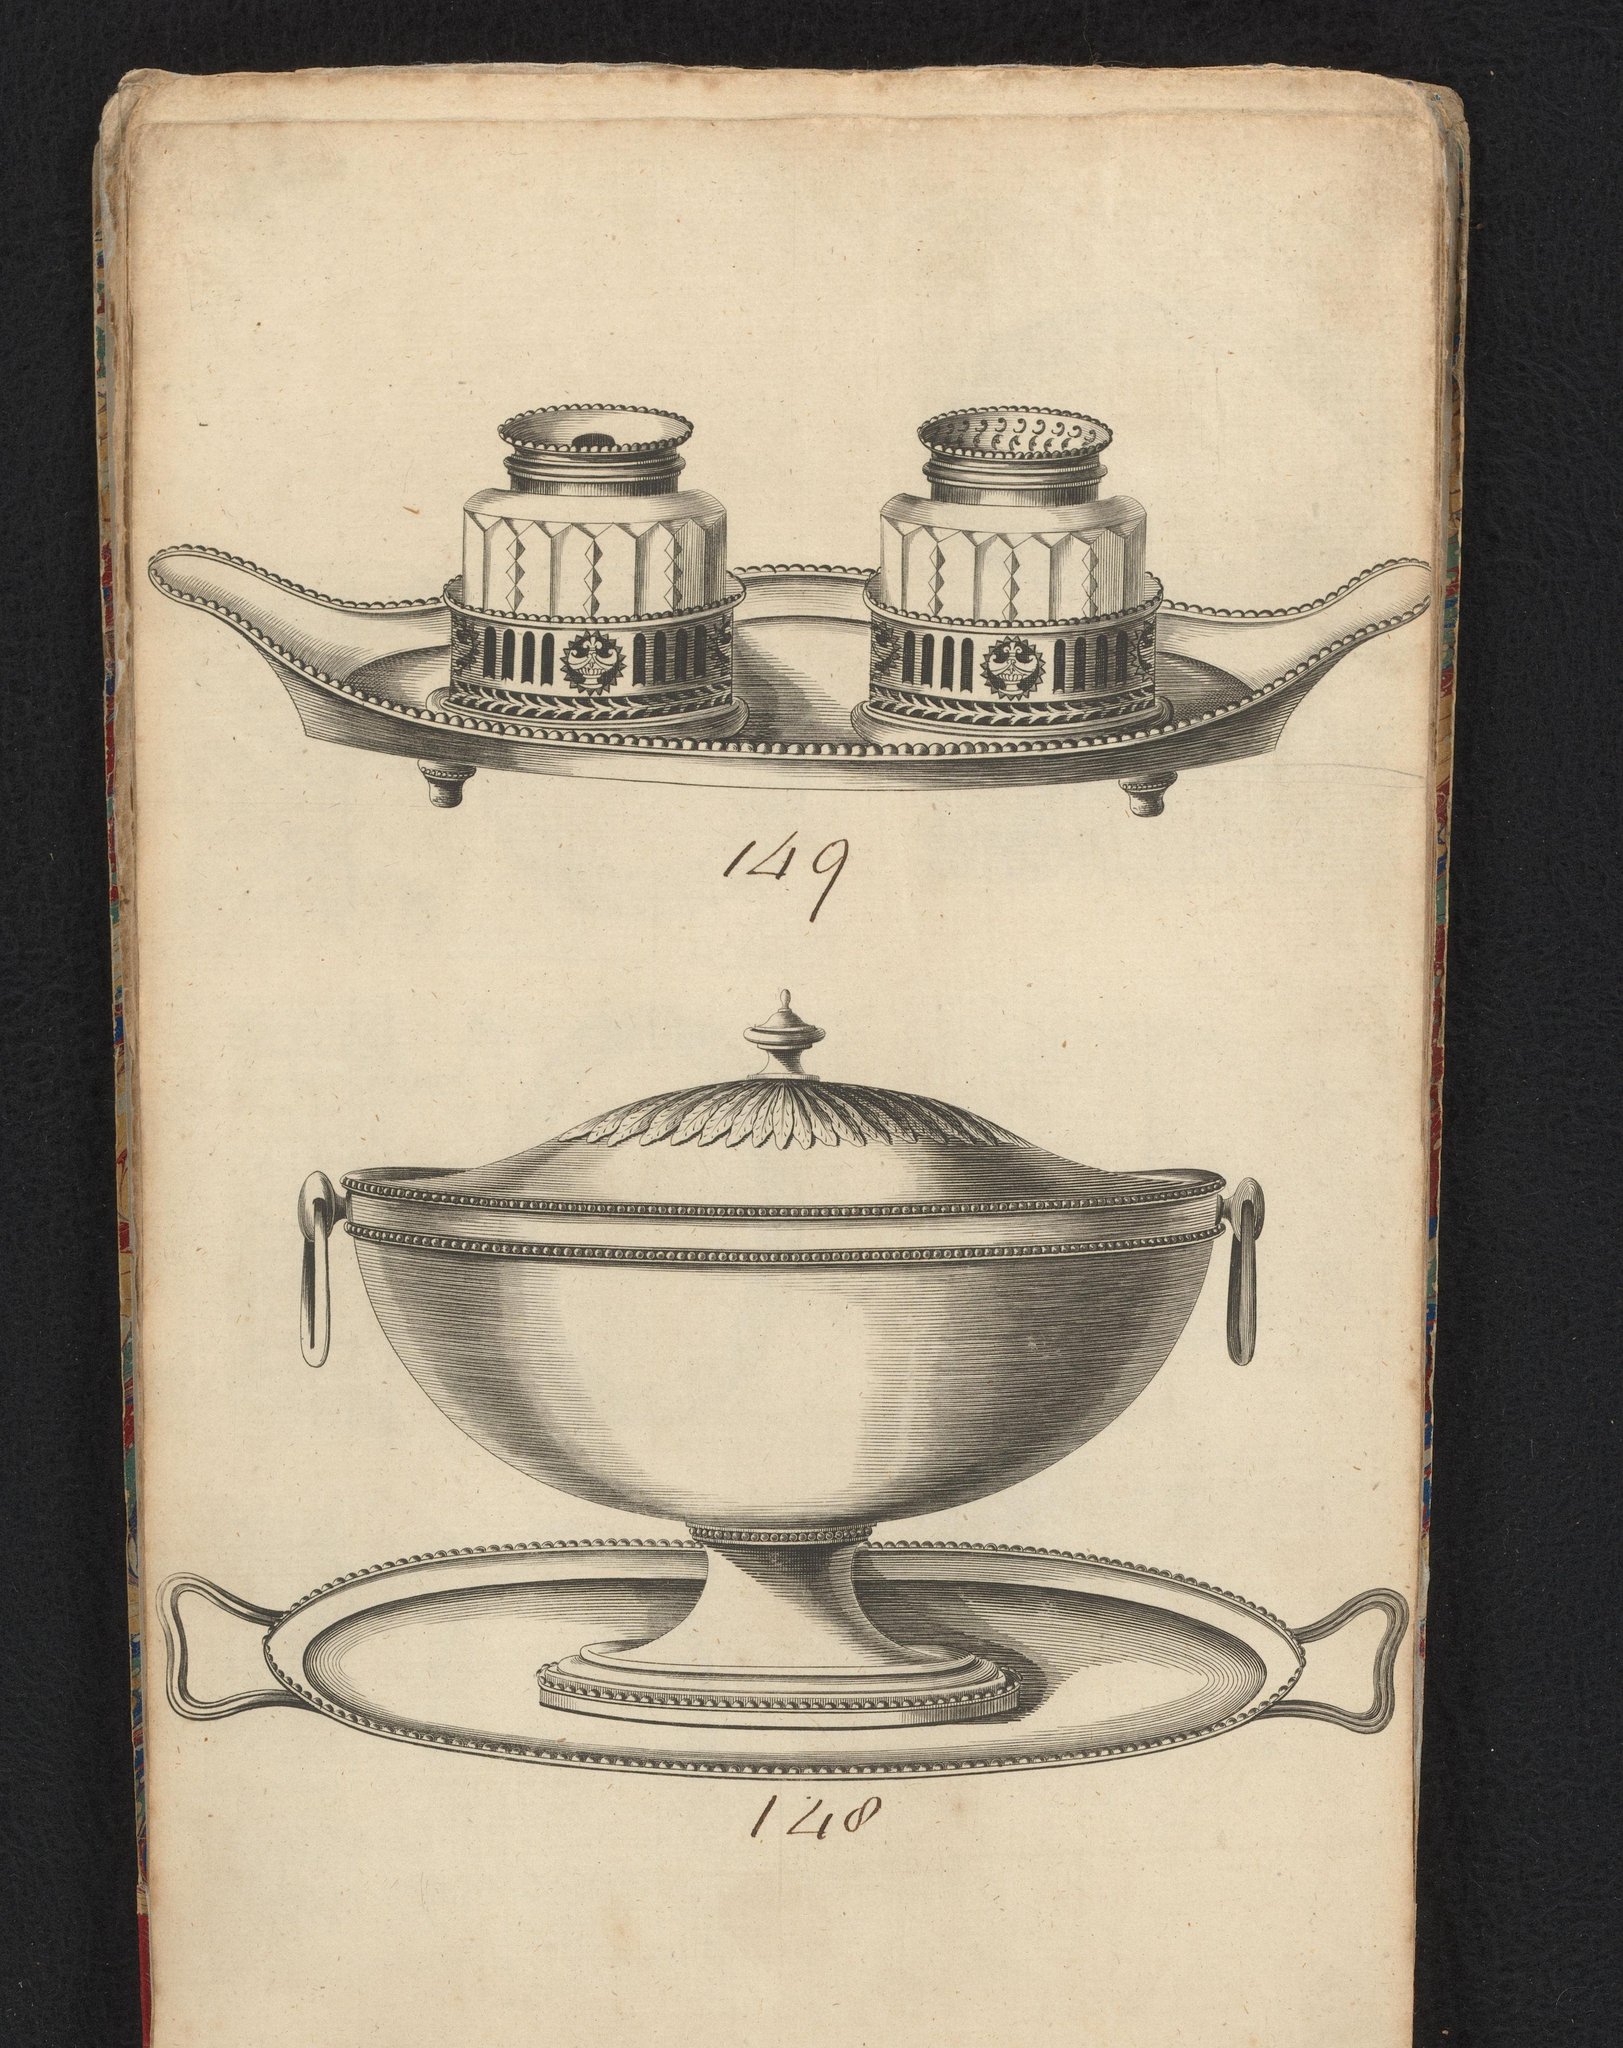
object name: ornament print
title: Ontwerpen voor een peper- en zoutstel en een terrine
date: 1784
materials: paper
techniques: engraving, etching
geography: england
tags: serving-dish, platter, salt-cellar, salt-shaker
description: Ontwerpen voor een peper- en zoutstel en een terrine, op het volle blad. Onderaan handgeschreven nrs. 148 en 149. Onderdeel van een catalogus met assortiment modellen van Sheffield verzilverd vaatwerk (pleet) door Matthew Boulton.